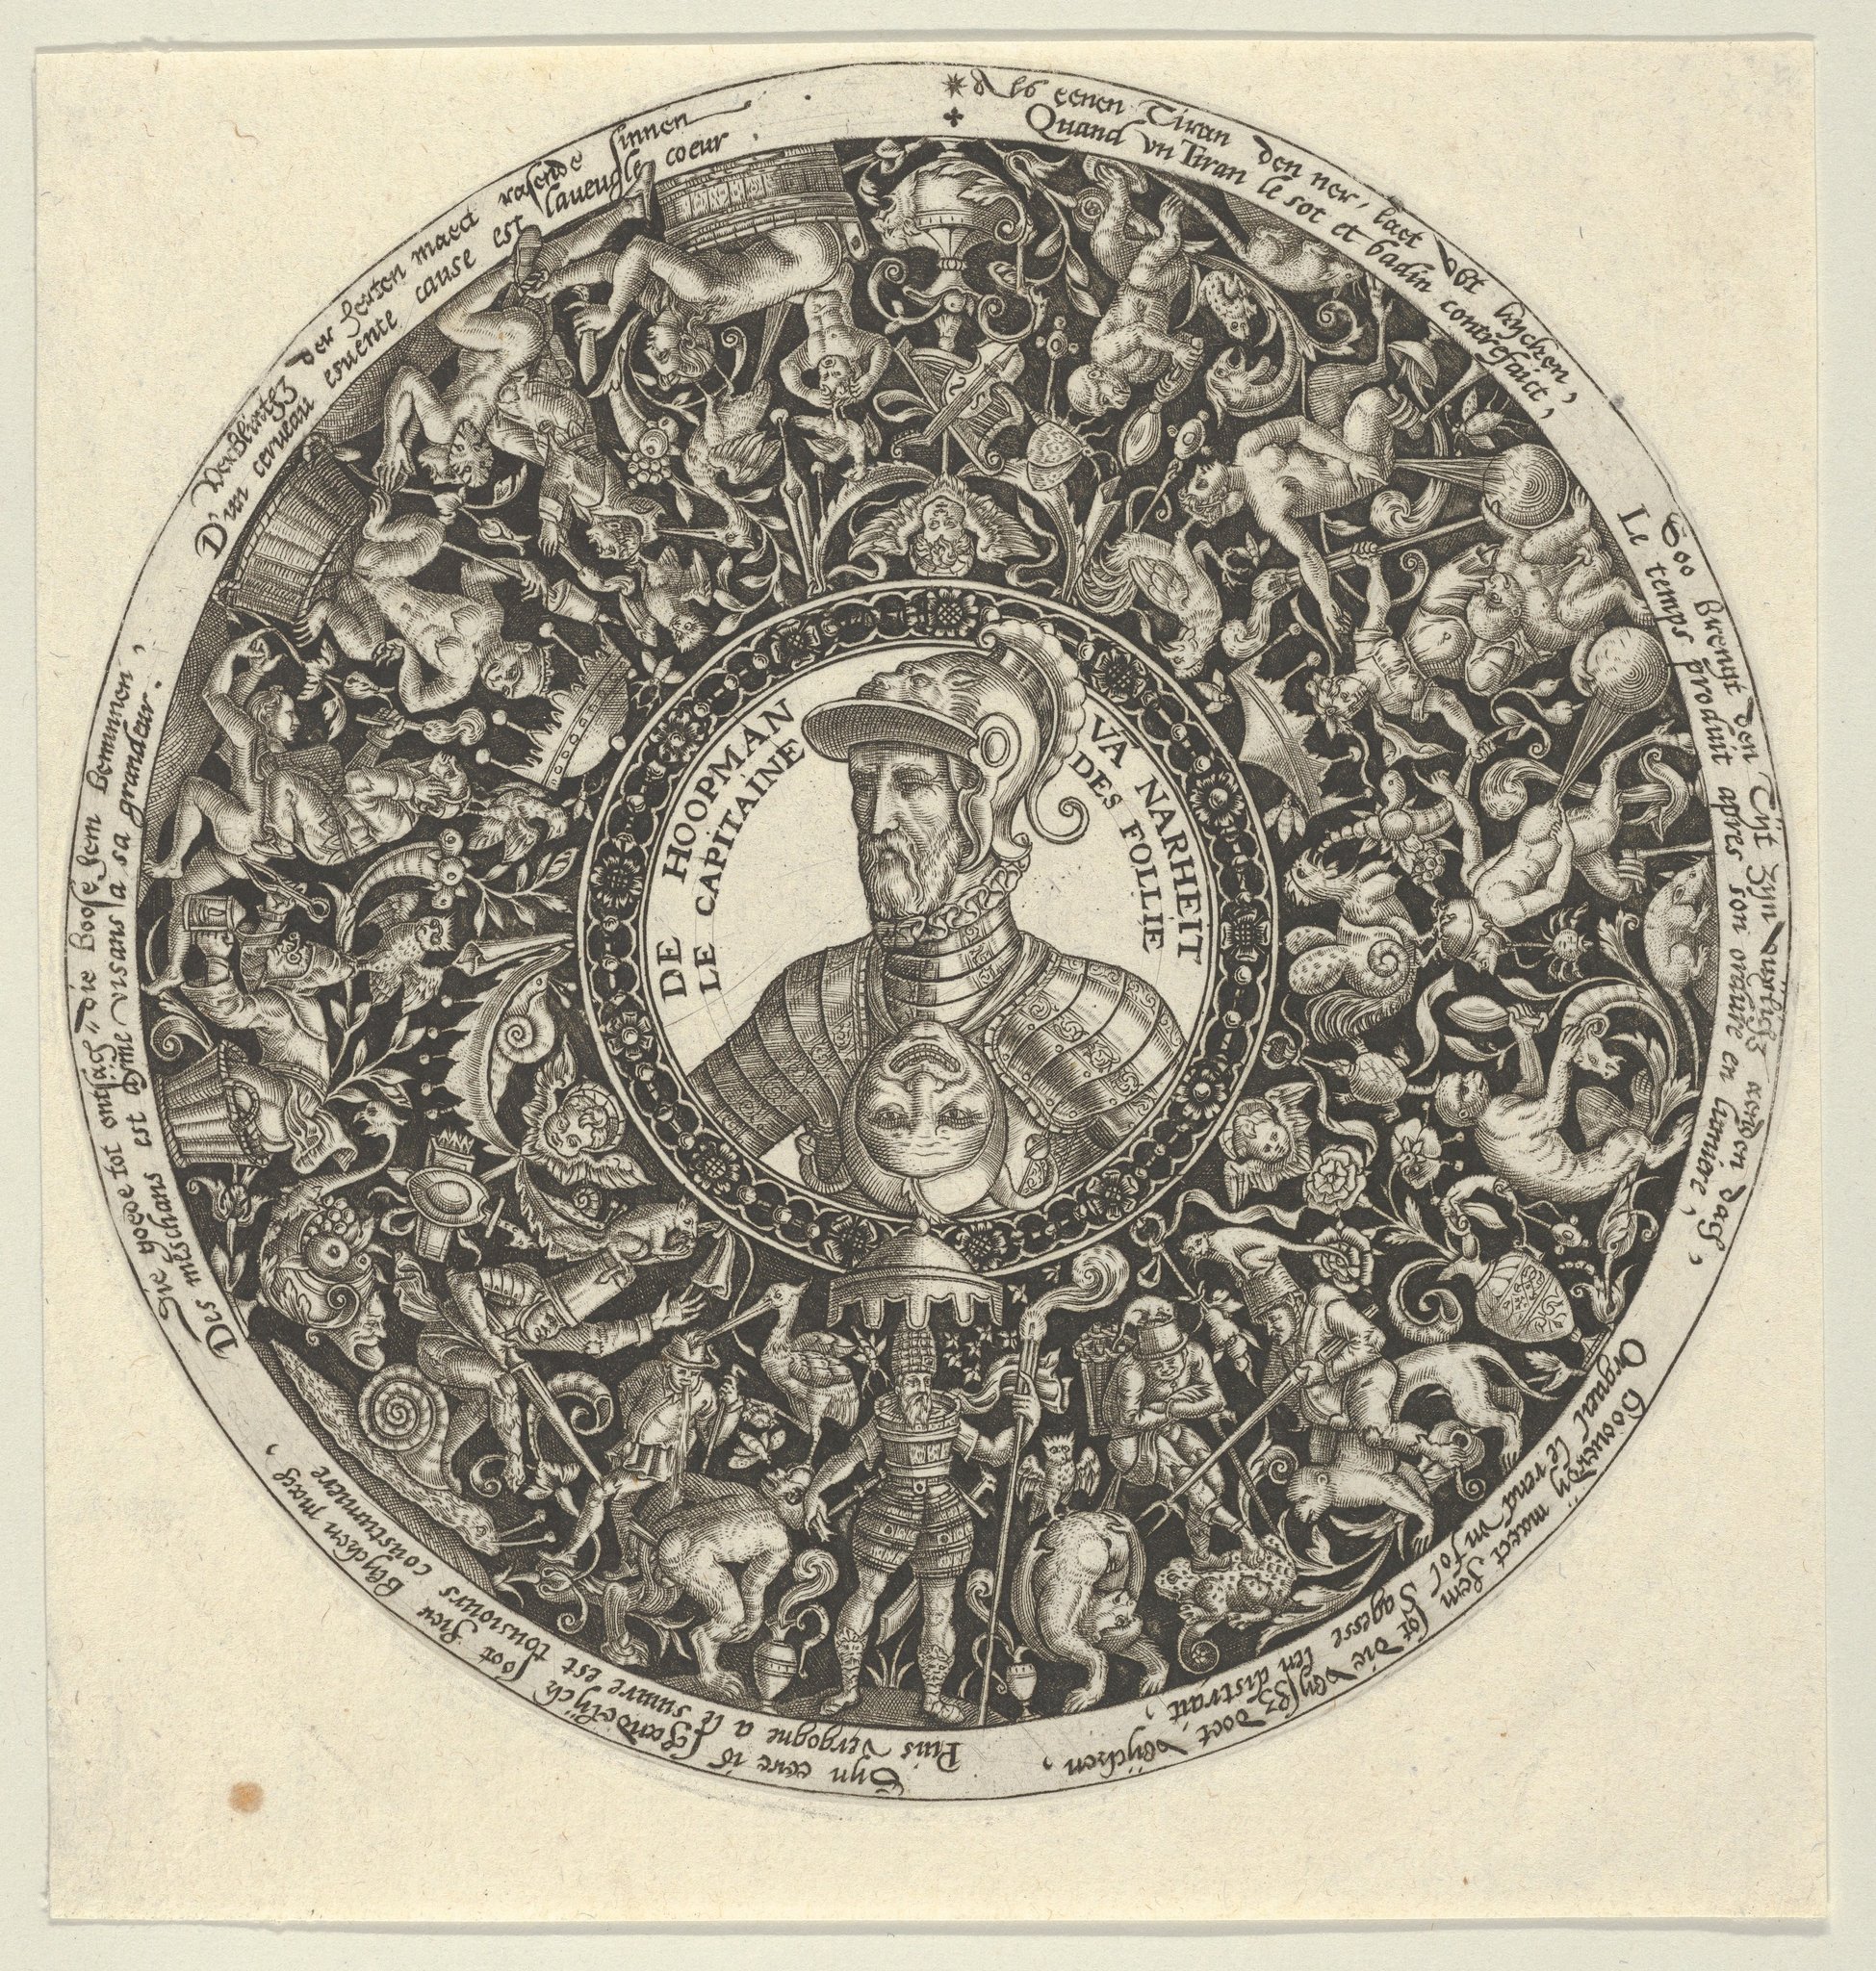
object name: print ornament architecture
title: Portrait of the Duke of Alva, from a Series of Tazza Designs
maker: theodor de bry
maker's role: artist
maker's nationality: netherlandish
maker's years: 1528-1598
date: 1588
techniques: engraving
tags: armor,weapons,men,portraits